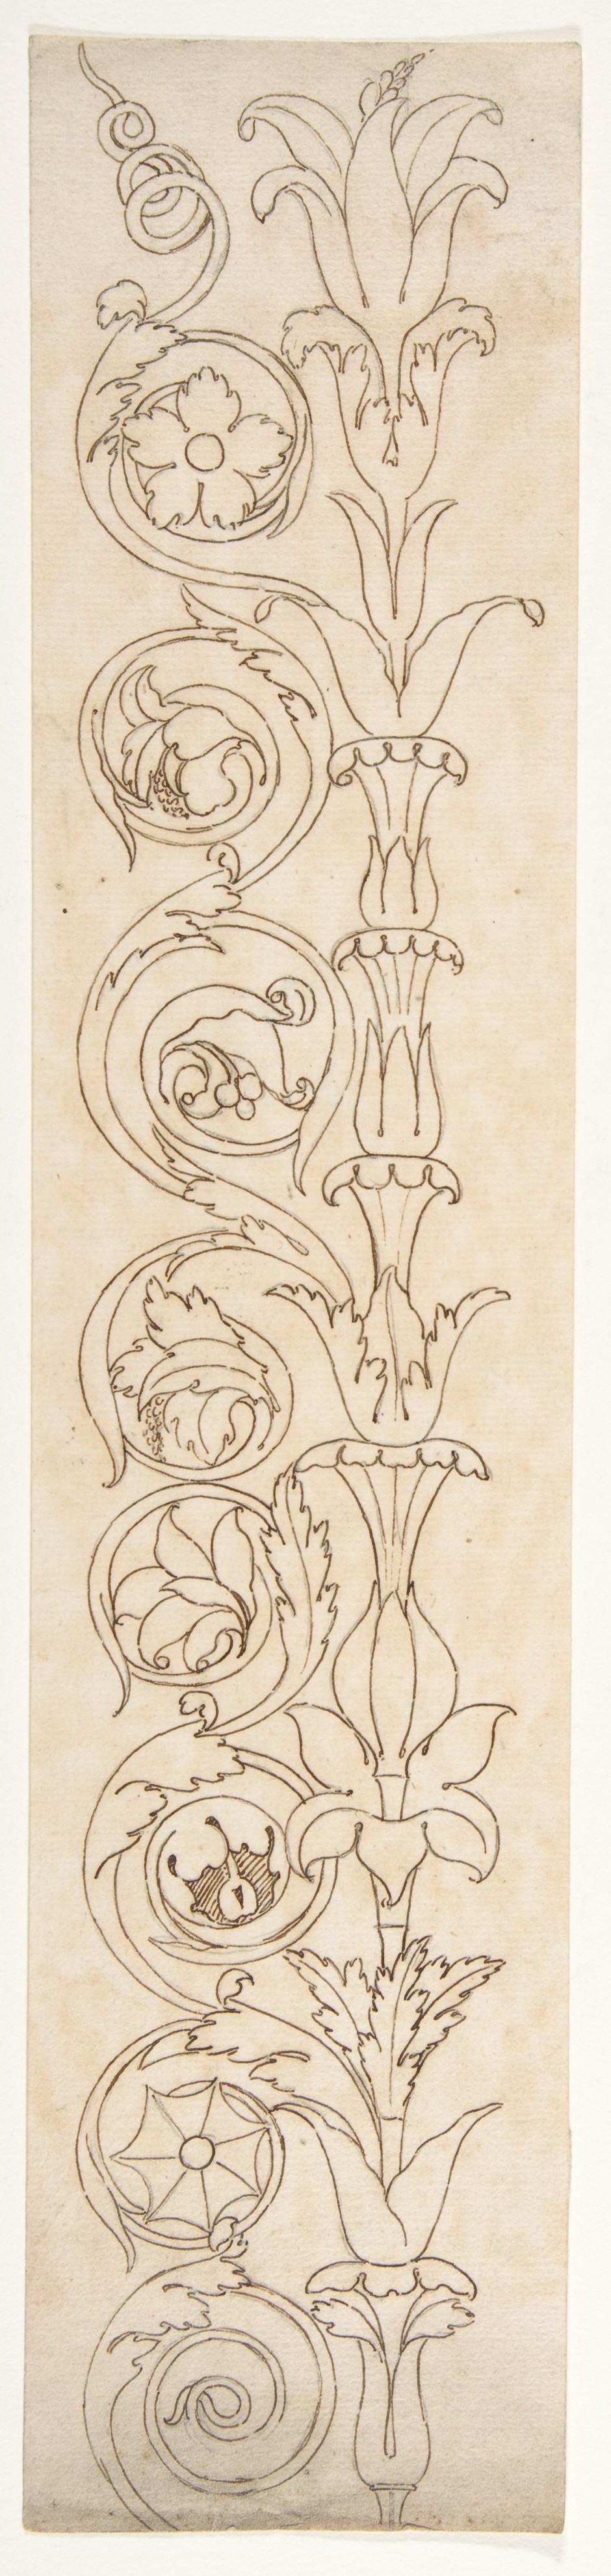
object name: collection ornament architecture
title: Ornamental drawings (recto) blank (verso)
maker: anonymous, french, 16th century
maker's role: draftsman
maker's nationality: french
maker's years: 1500-1600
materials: chalk, ink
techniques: incising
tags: ornament